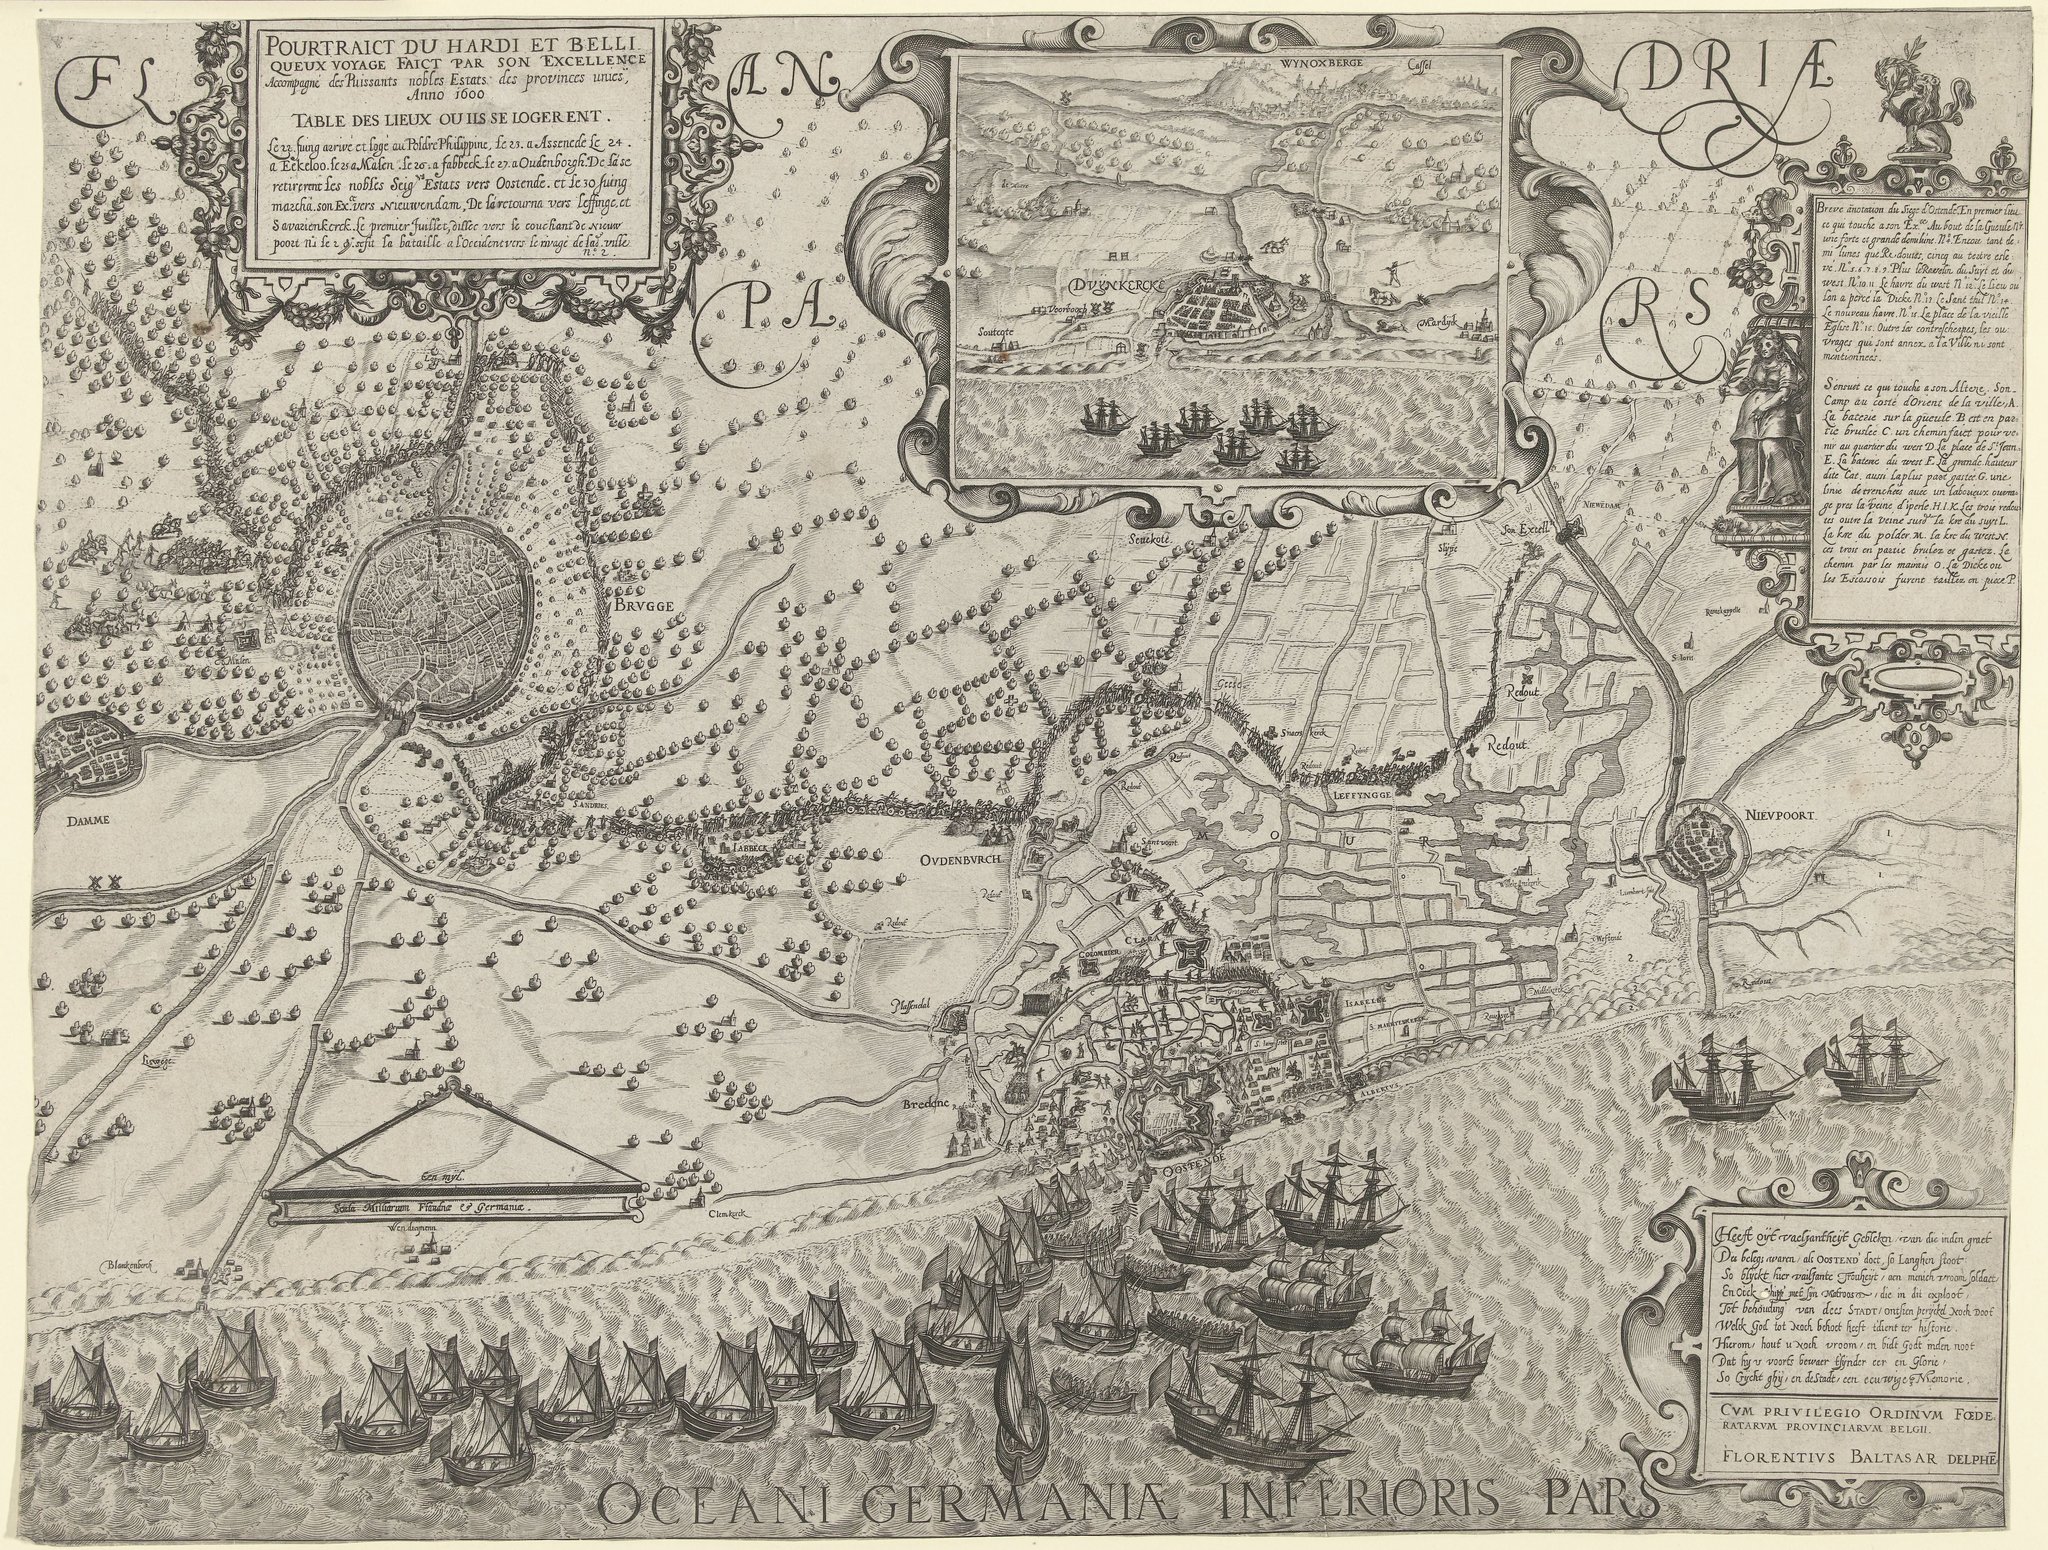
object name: print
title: Tocht van het leger van Maurits naar Oostende (rechterblad), 1600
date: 1600-1601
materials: paper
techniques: engraving, etching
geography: delft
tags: troop movements, transportation, maps of separate countries or regions, bruges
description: Tocht van het Staatse leger onder prins Maurits naar Oostende, 19-27 juni 1600. Rechterhelft van twee bladen. De Staatse vloot voor Oostende. Boven trekt het Staatse leger door Vlaanderen, om Brugge en Oostende heen in de richting van Nieuwpoort. Bovenaan cartouches met de titel, een gezicht op Duinkerke en opschriften en legenda in het Frans. Onderaan een vers in het Nederlands en de privilege.